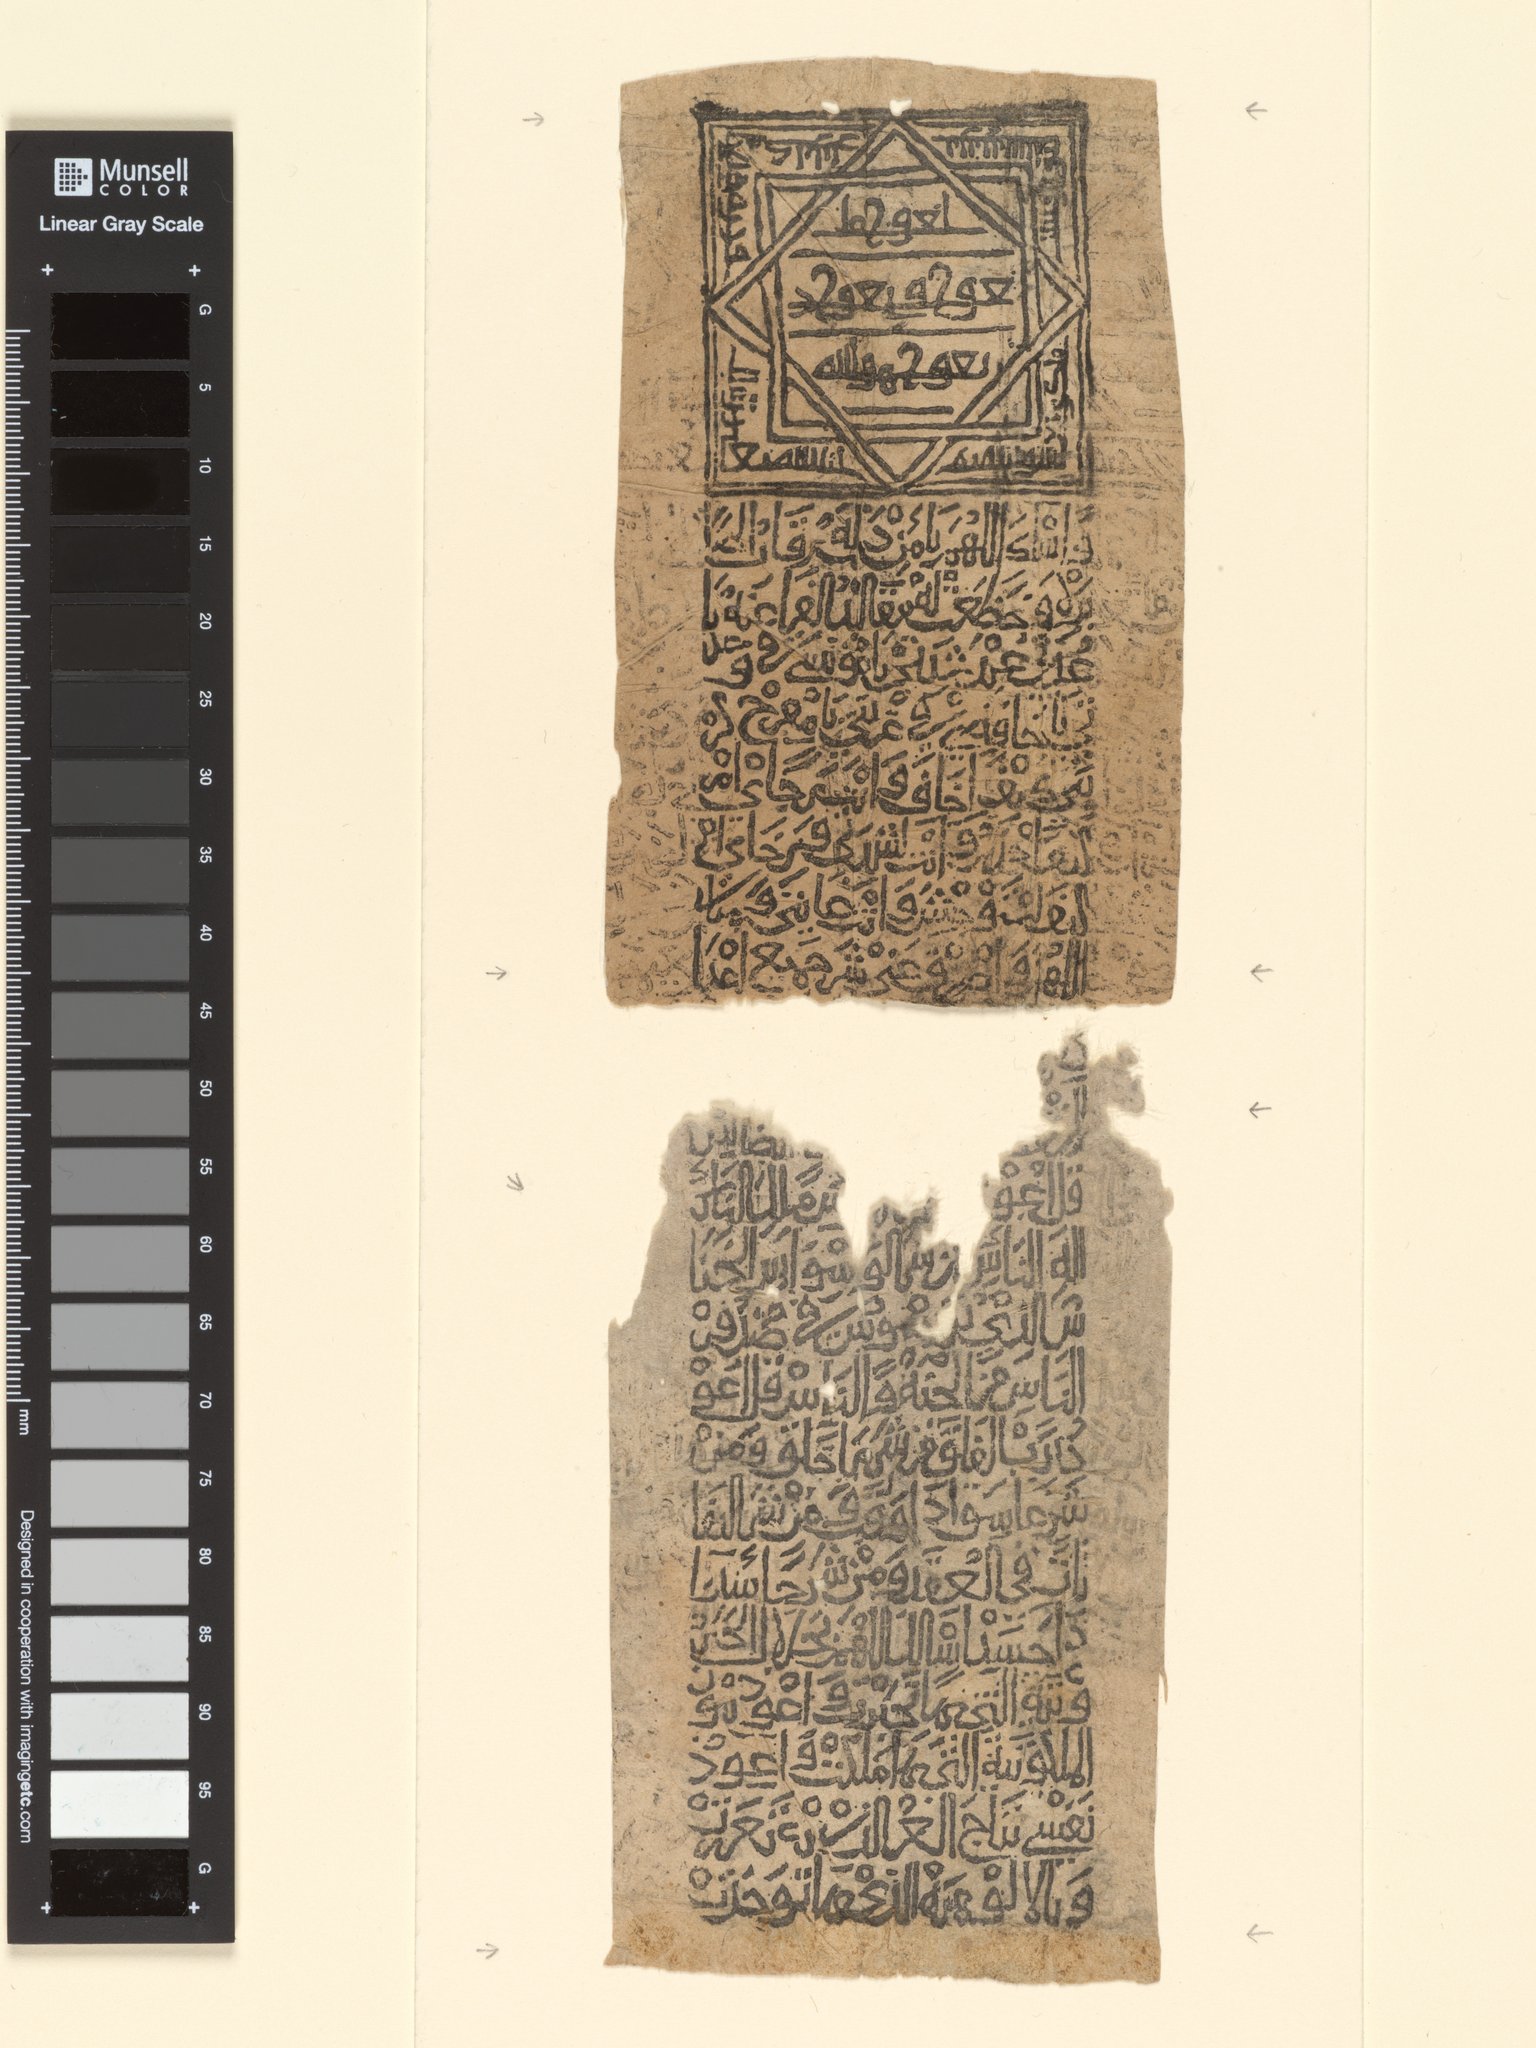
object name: scroll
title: Talismanic Scroll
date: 1001-1100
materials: ink, paper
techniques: printing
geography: egypt